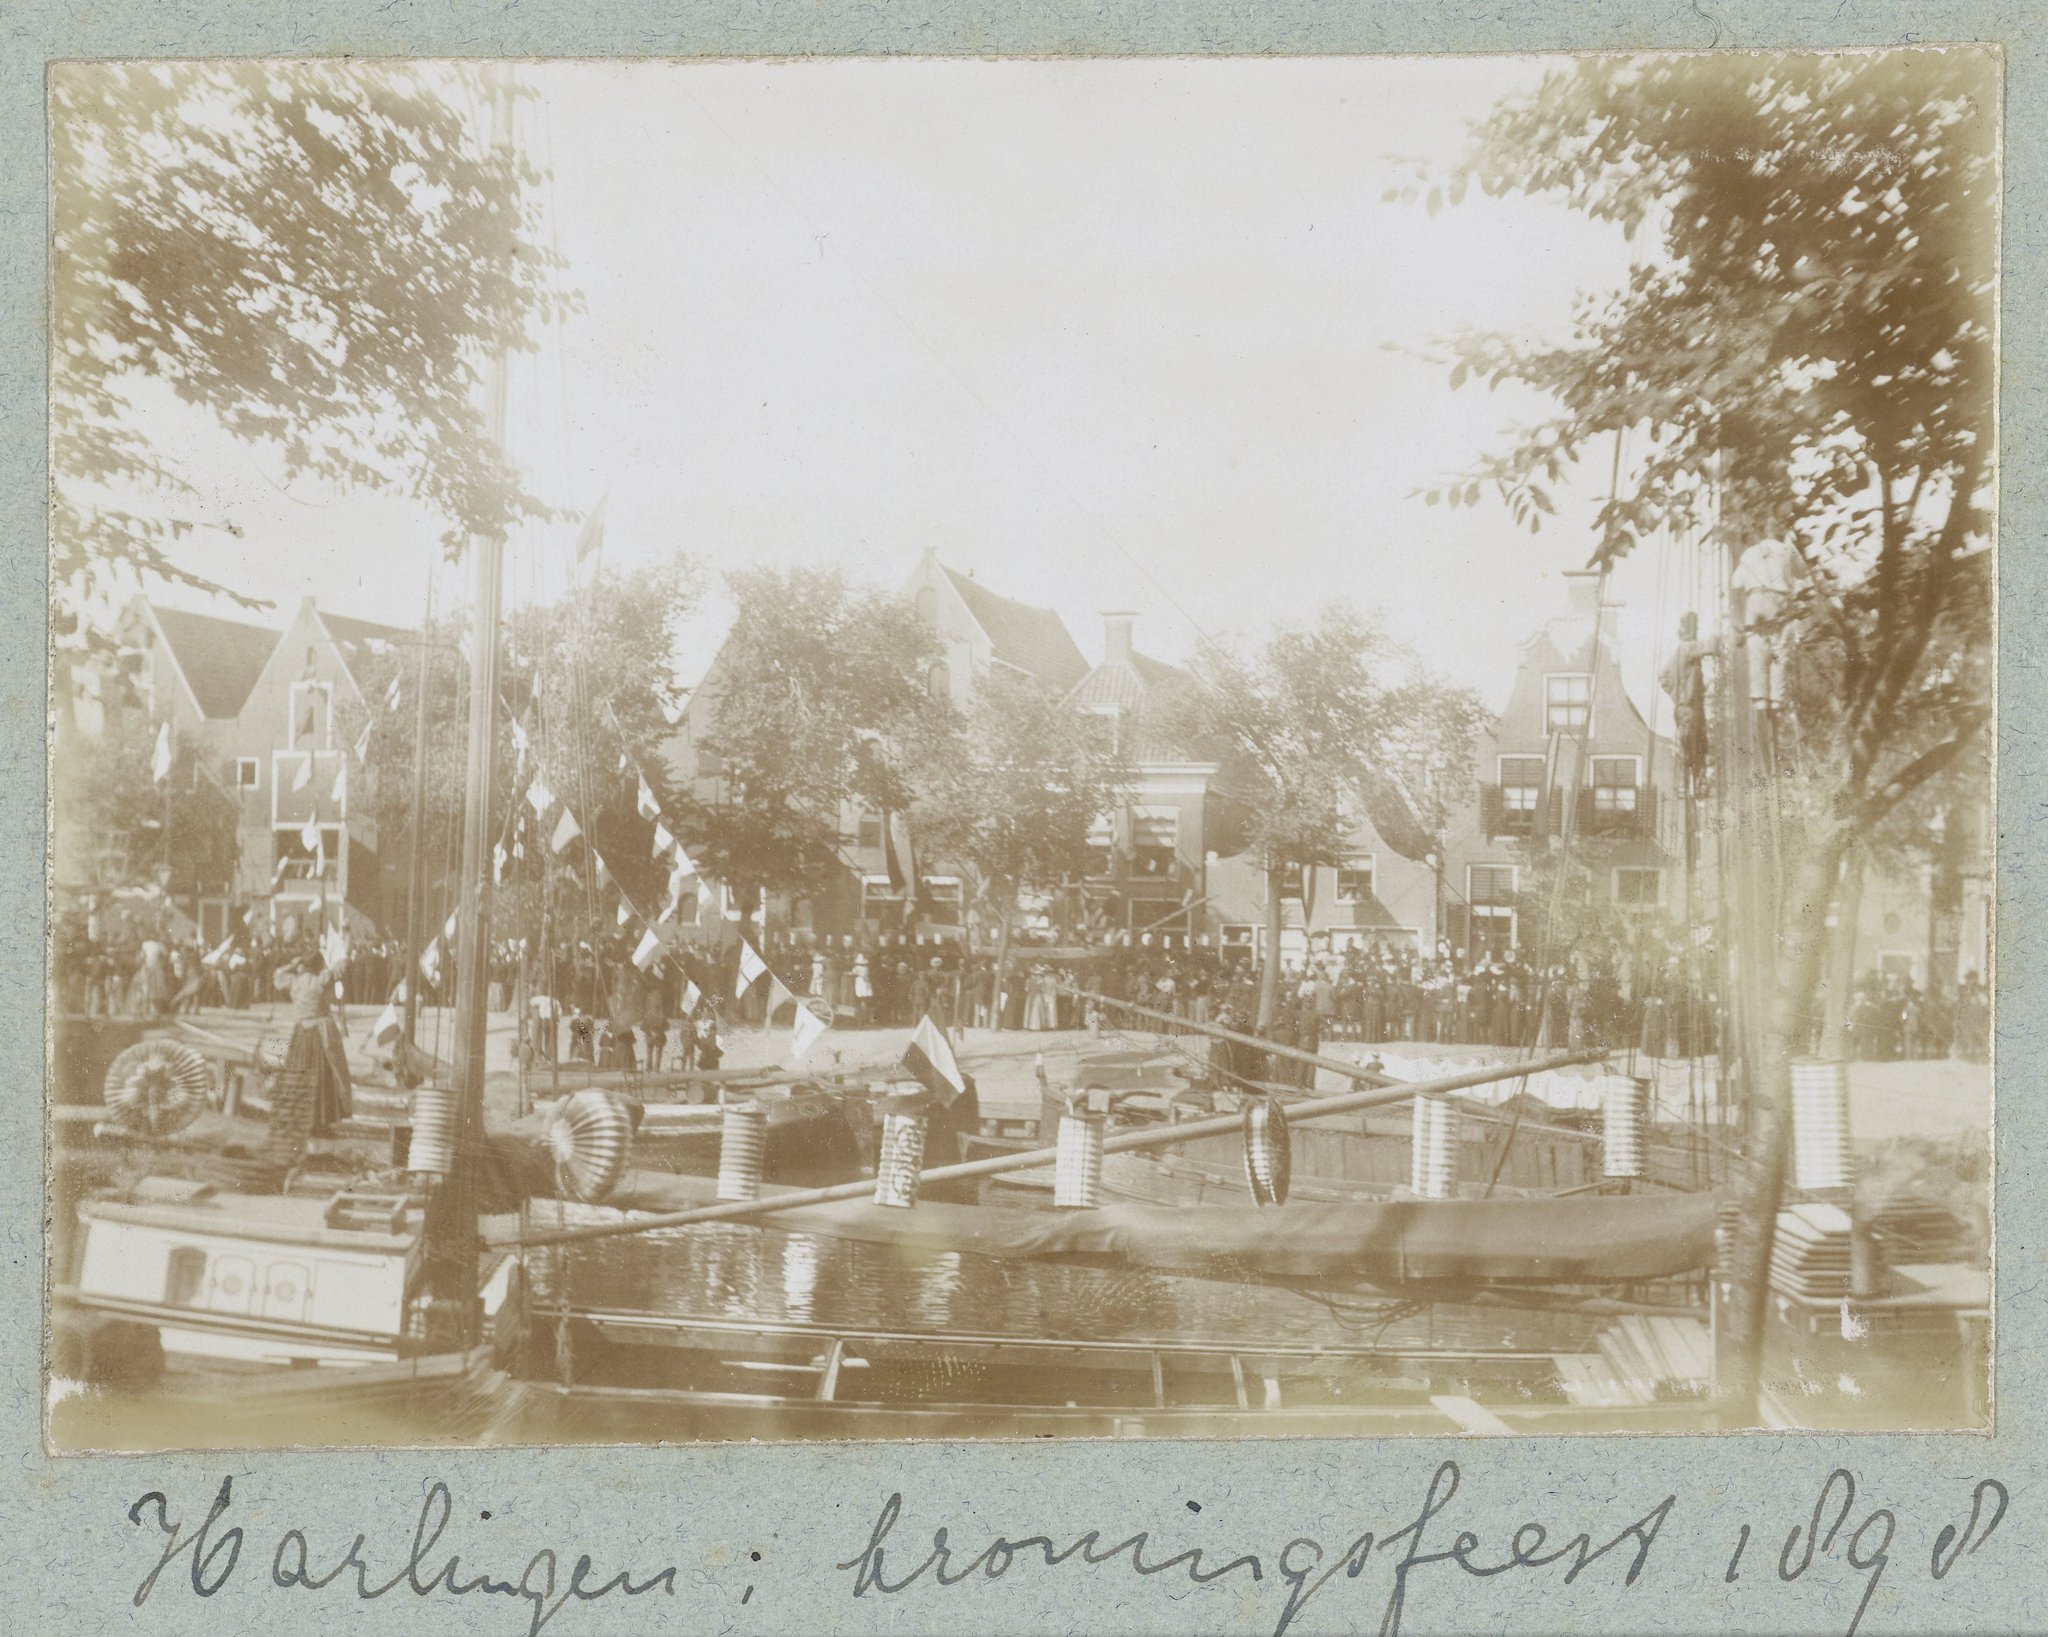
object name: photograph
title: Havengezicht met versierde kade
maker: frits freerks fontein fz.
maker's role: fotograaf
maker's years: 1882-1928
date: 1898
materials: cardboard, paper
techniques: gelatin silver print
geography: netherlands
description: De kade en de schepen zijn versierd met vlaggen en lampionnen voor de inhuldiging van koningin Wilhelmina. Op de kade staat een grote rij mensen. Foto uit album 'Photographieën".